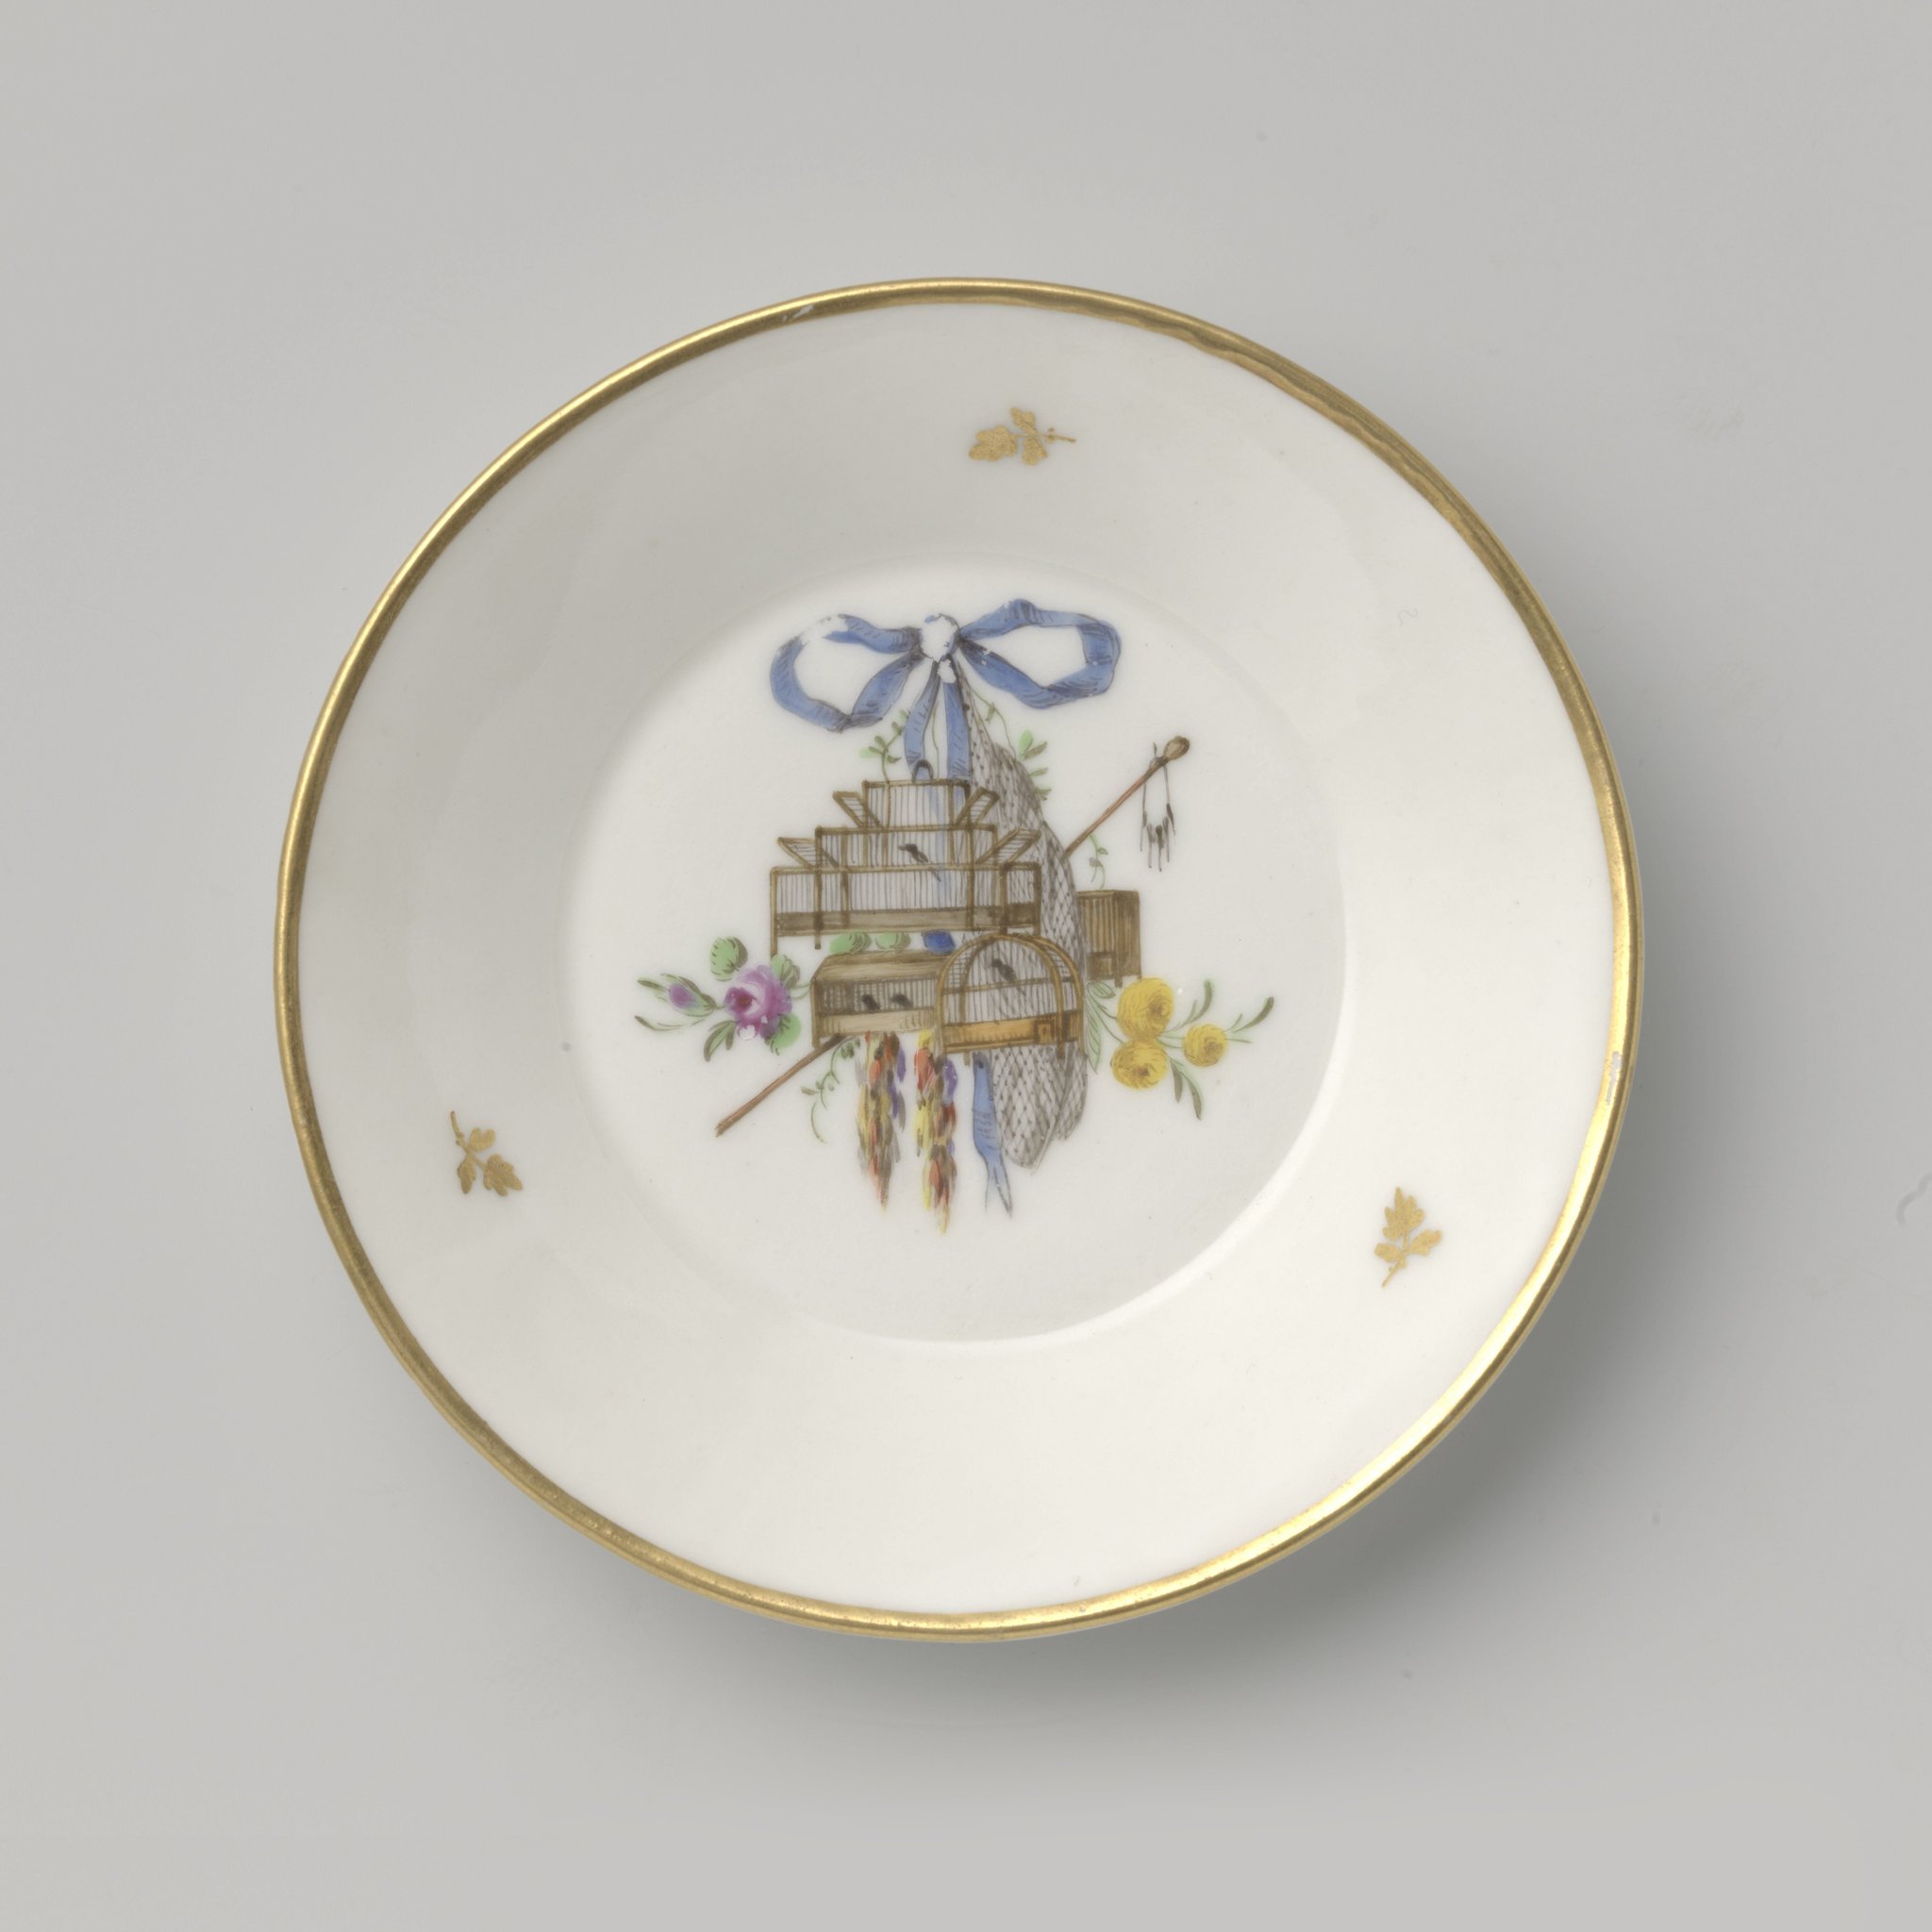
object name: platter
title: Schotel behorend bij een theeservies met decoratie van trofeeën aan gestrikte linten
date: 1809-1814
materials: porcelain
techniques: painted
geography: nieuwer-amstel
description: Theeservies bestaande uit een theepot, een suikerpot, een spoelkom en twaalf koppen en schotels veelkleurig beschilderd met trofeeën hangend aan blauwe strikken. De trofeeën hebben betrekking op diverse beroepen. Gemerkt in zwart: Amstel (de suikerpot Amstel N. 805 en ingegrift A). Verschillende ingegrifte merken in de koppen en schotels.